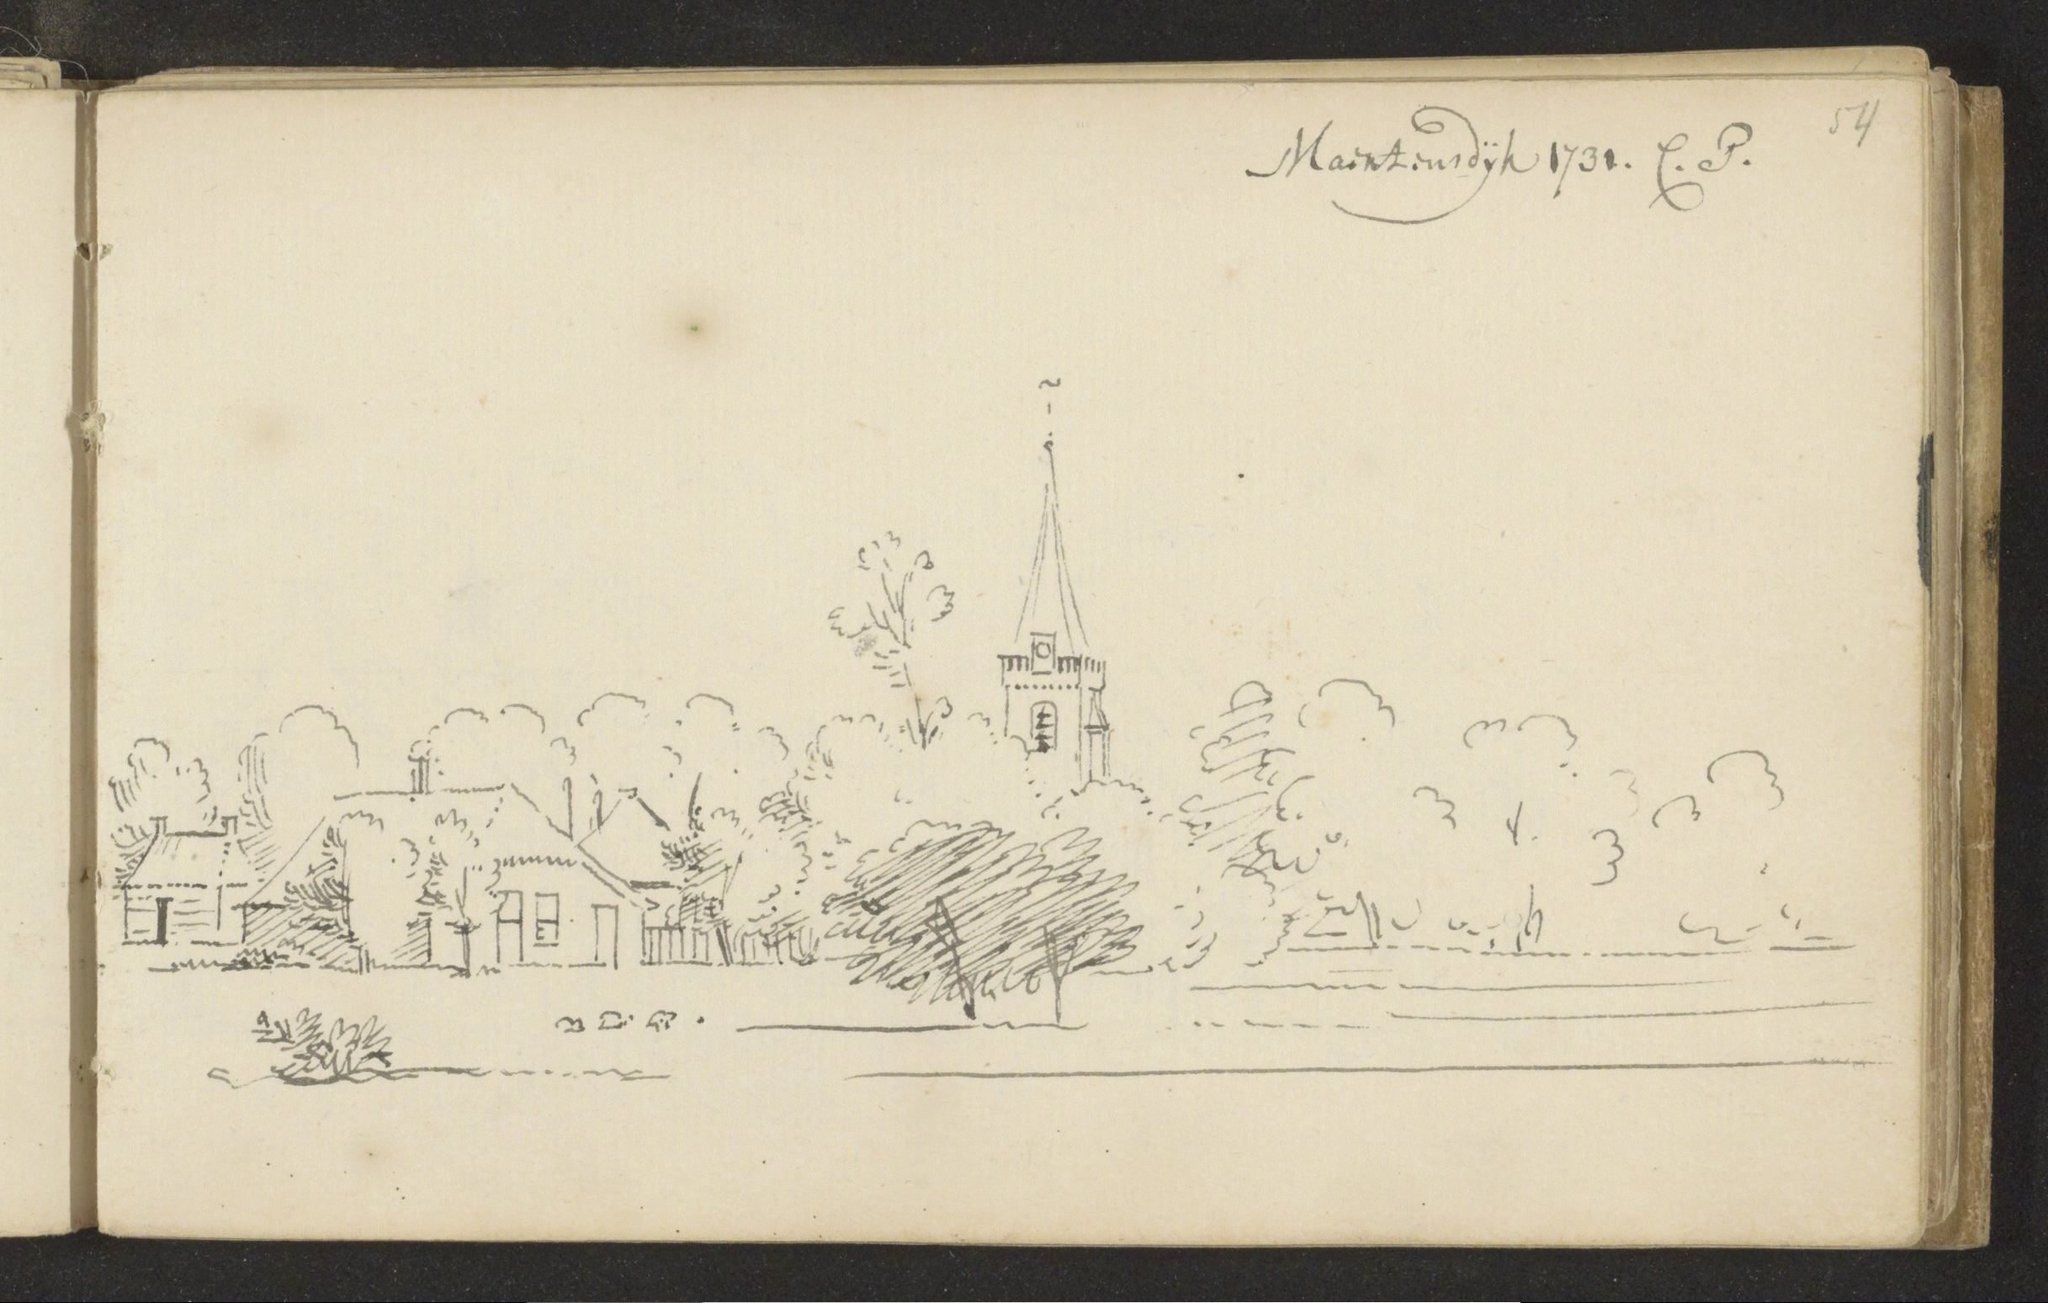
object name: sketchbook leaf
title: Gezicht op Maartensdijk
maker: abraham de haen (ii)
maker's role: draughtsman, print maker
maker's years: 1707-1748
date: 1731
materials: ink, paper, pencil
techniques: pen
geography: maartensdijk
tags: village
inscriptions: date and inscription: ‘Maertensdijk 1731.C.P.’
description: Blad 54 recto uit een schetsboek met 78 bladen.